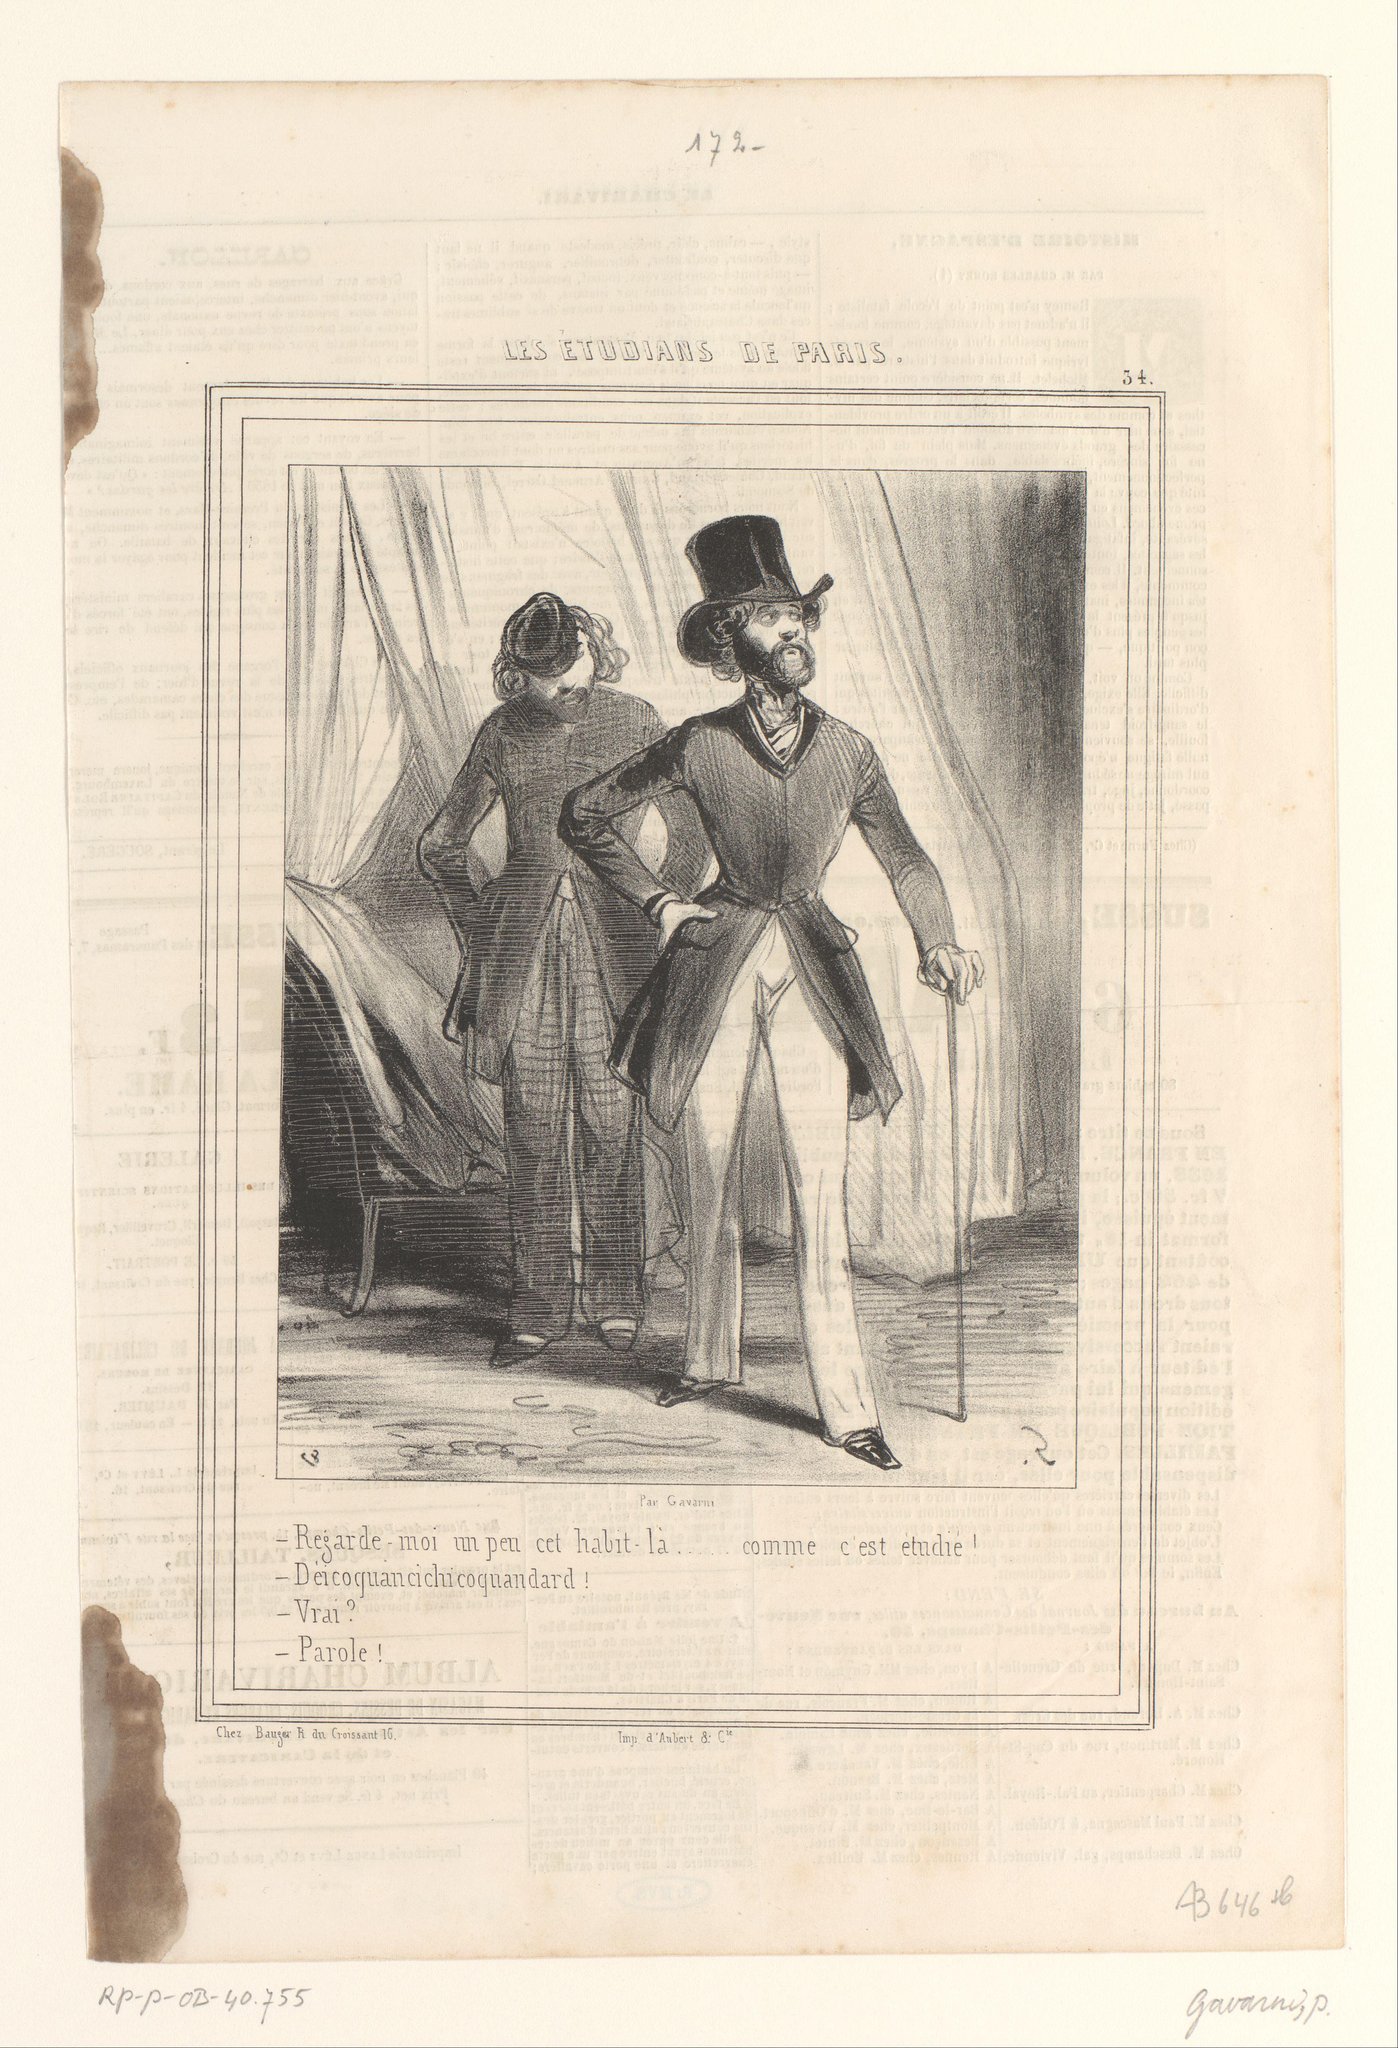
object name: print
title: Student vraagt een vriend zijn outfit te beoordelen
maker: paul gavarni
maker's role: draughtsman, print maker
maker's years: 1804-1866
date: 1840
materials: paper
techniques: lithograph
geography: paris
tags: standing figure, dressing oneself, getting dressed, bedroom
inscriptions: collector's mark: Lugt 2228a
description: Prent gebruikt voor: Le Charivari, 12 juni 1840.